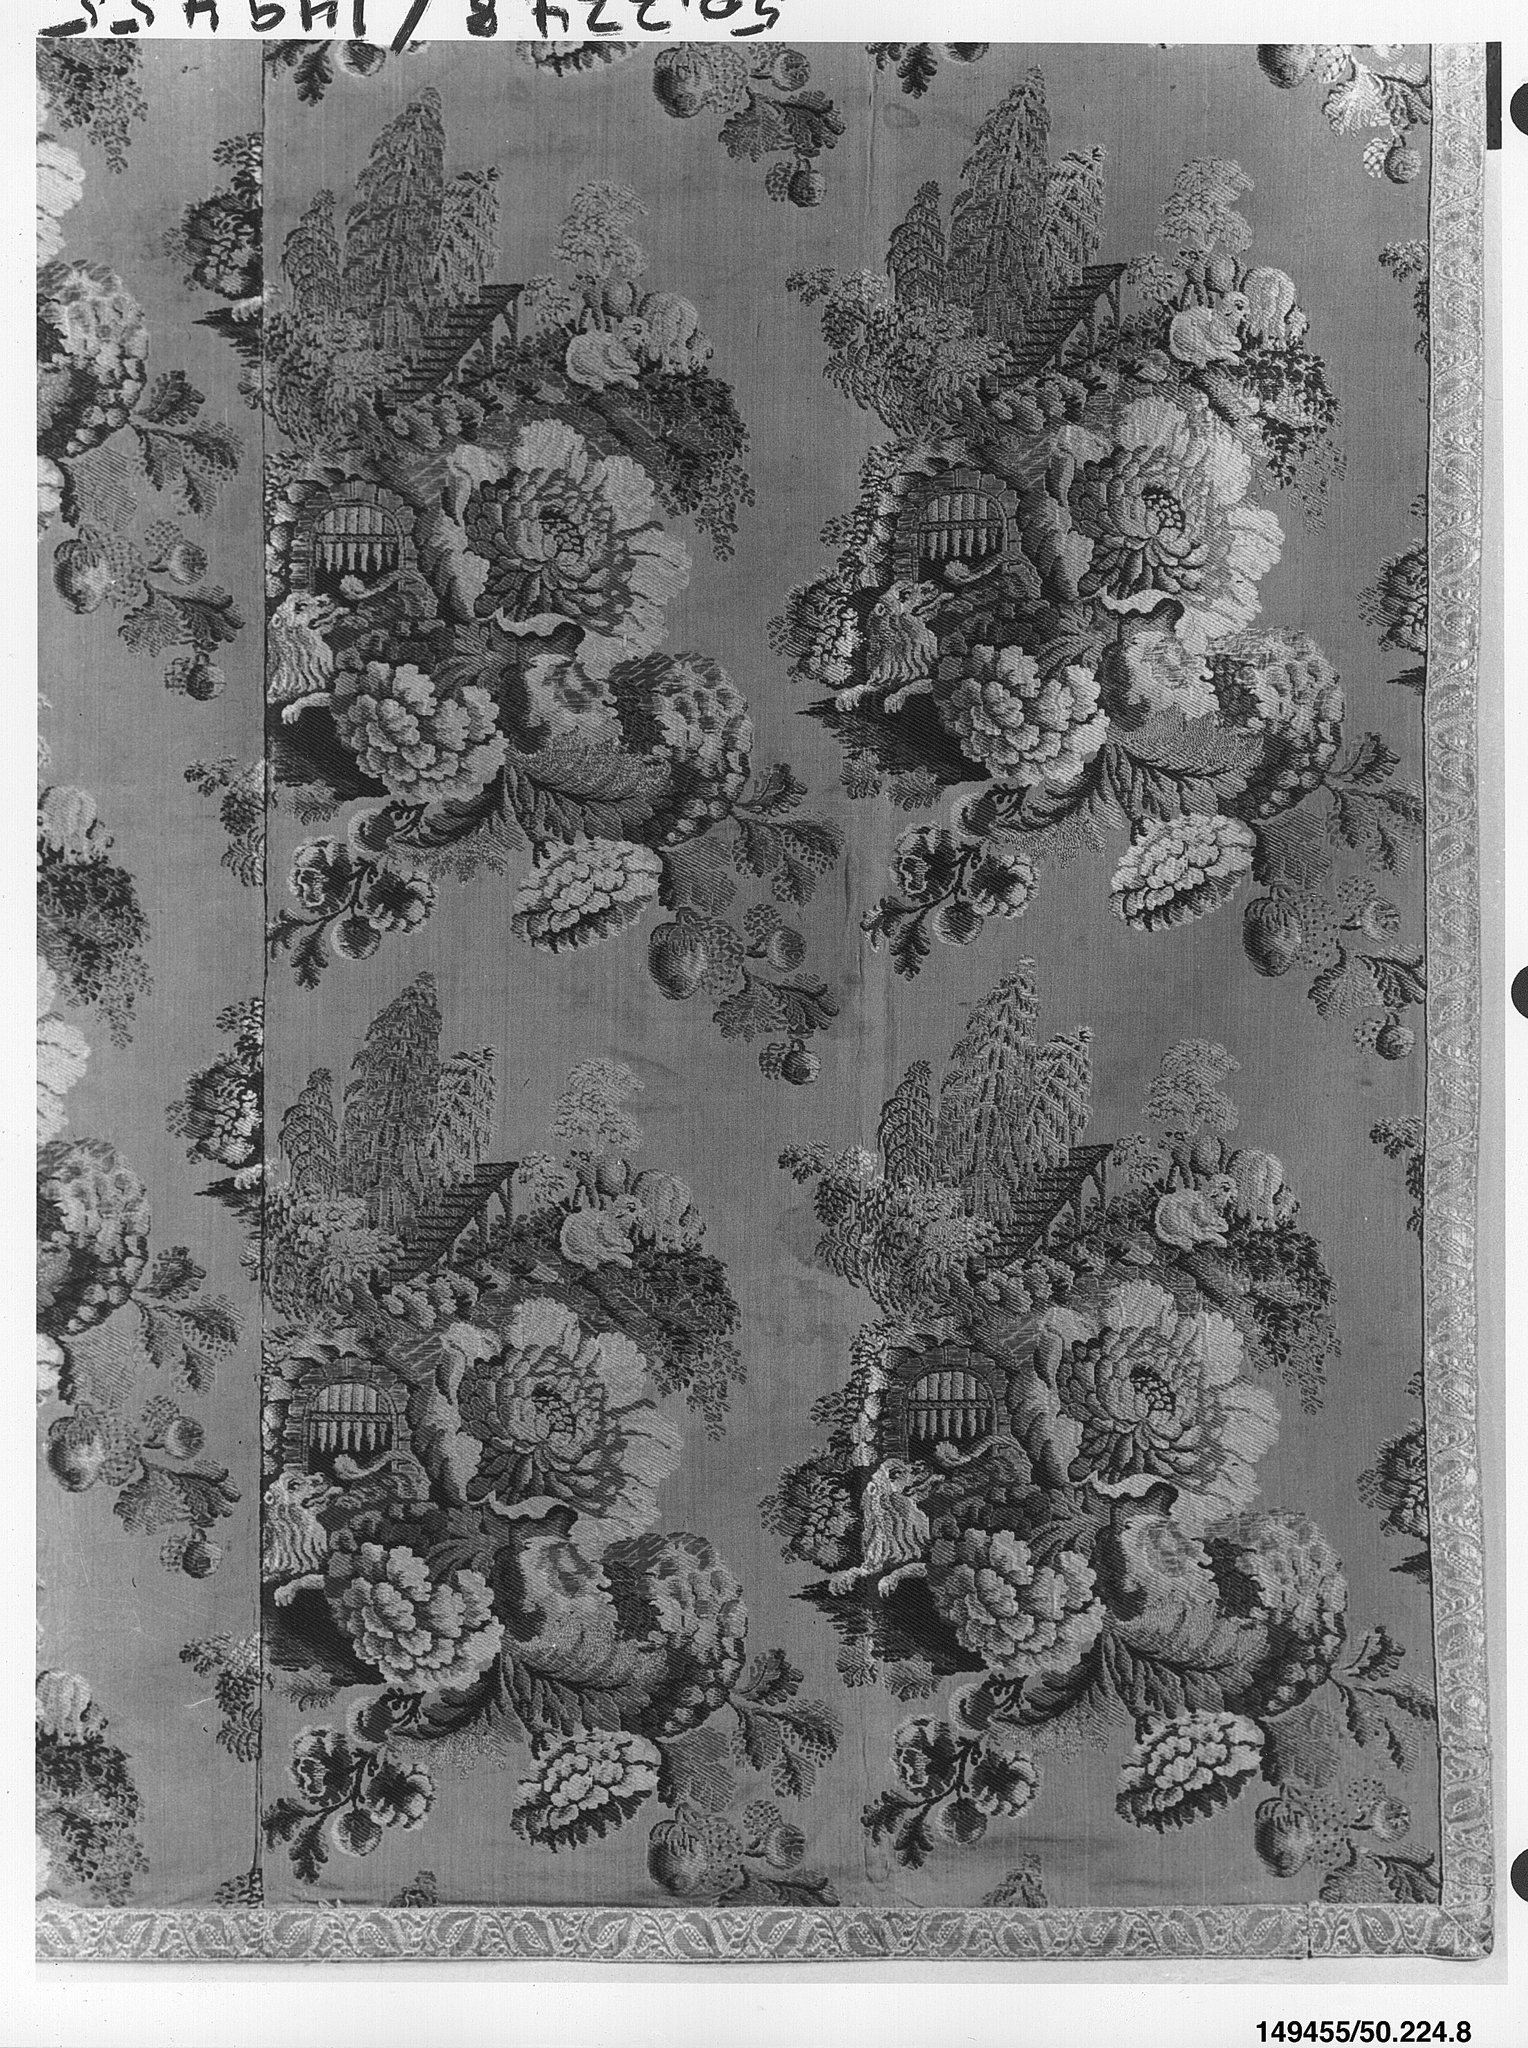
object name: piece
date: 1735-1740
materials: metal thread, silk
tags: animals,flowers